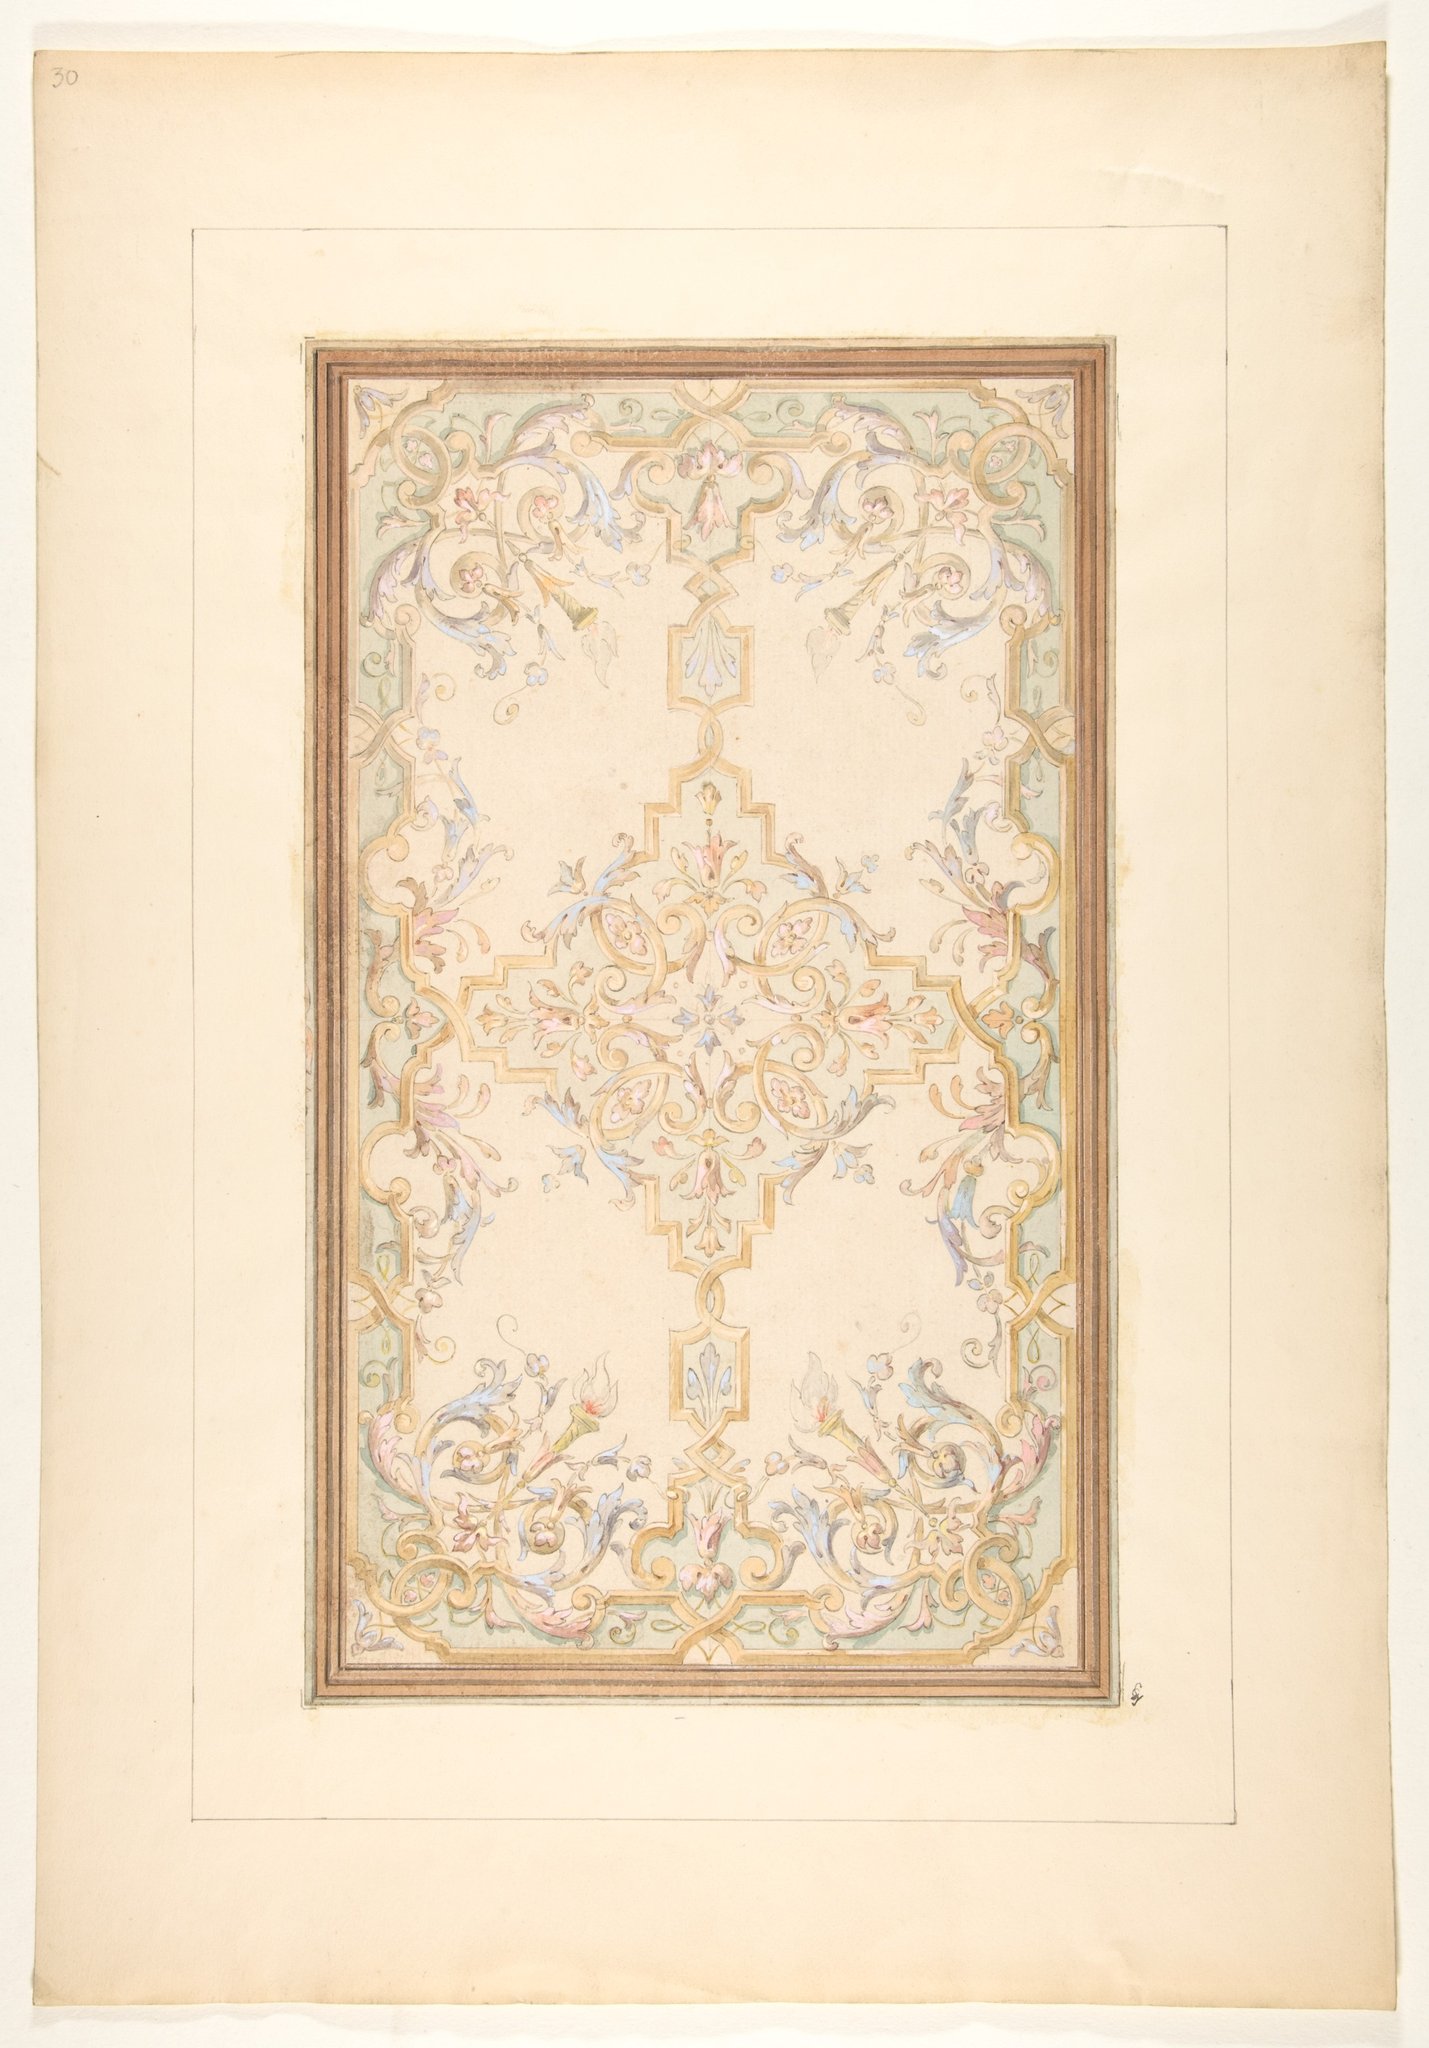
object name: drawing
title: Design for a ceiling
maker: jules-edmond-charles lachaise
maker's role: artist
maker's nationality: french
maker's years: 1897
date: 1851-1900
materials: gouache, graphite, watercolor